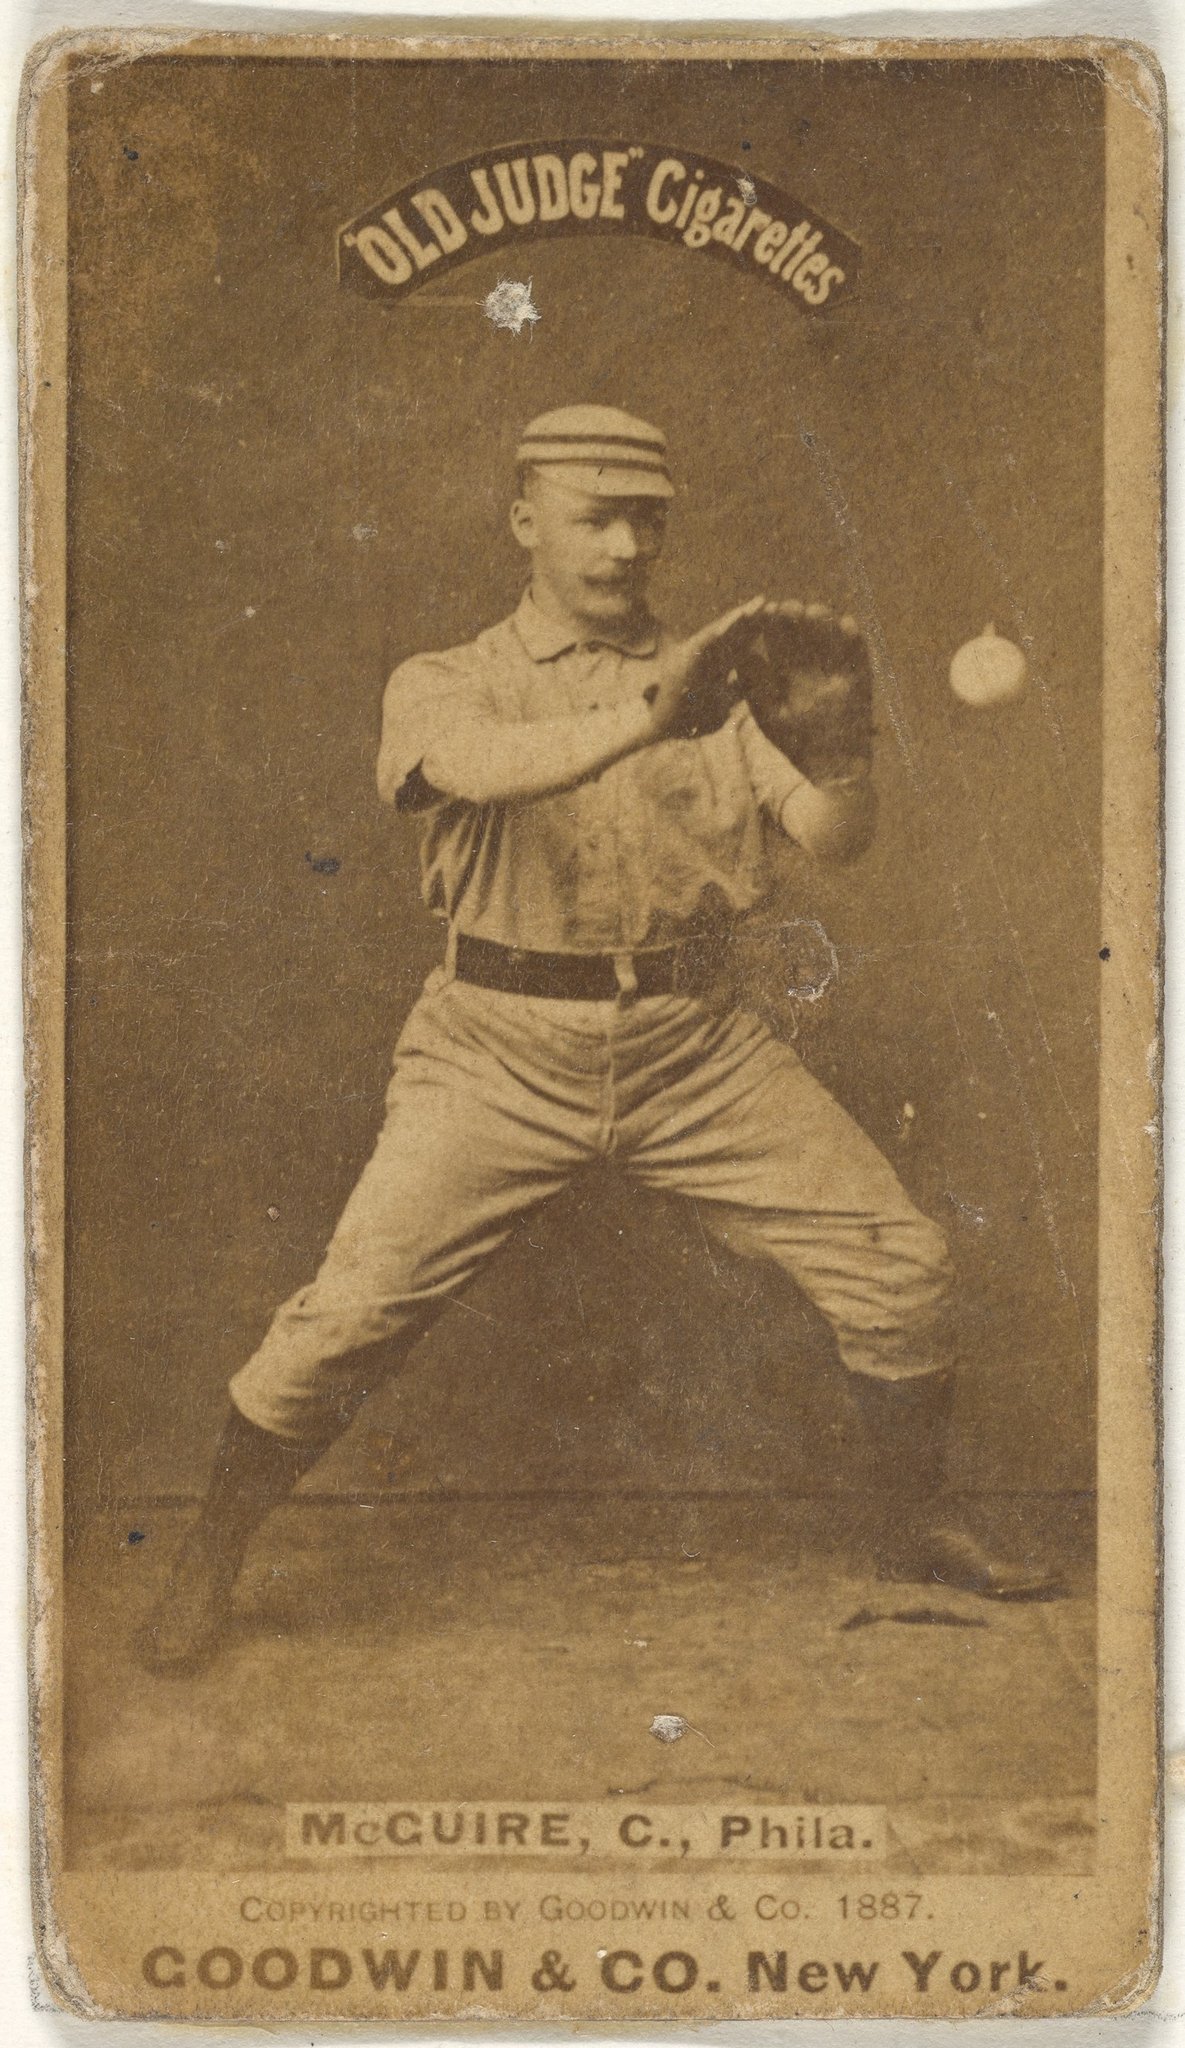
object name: baseball card, photograph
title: James Thomas "Deacon" McGuire, Catcher, Philadelphia, from the Old Judge series (N172) for Old Judge Cigarettes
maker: goodwin & company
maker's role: publisher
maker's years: 1850-1950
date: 1887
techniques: albumen silver print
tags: men,portraits,baseball,athletes